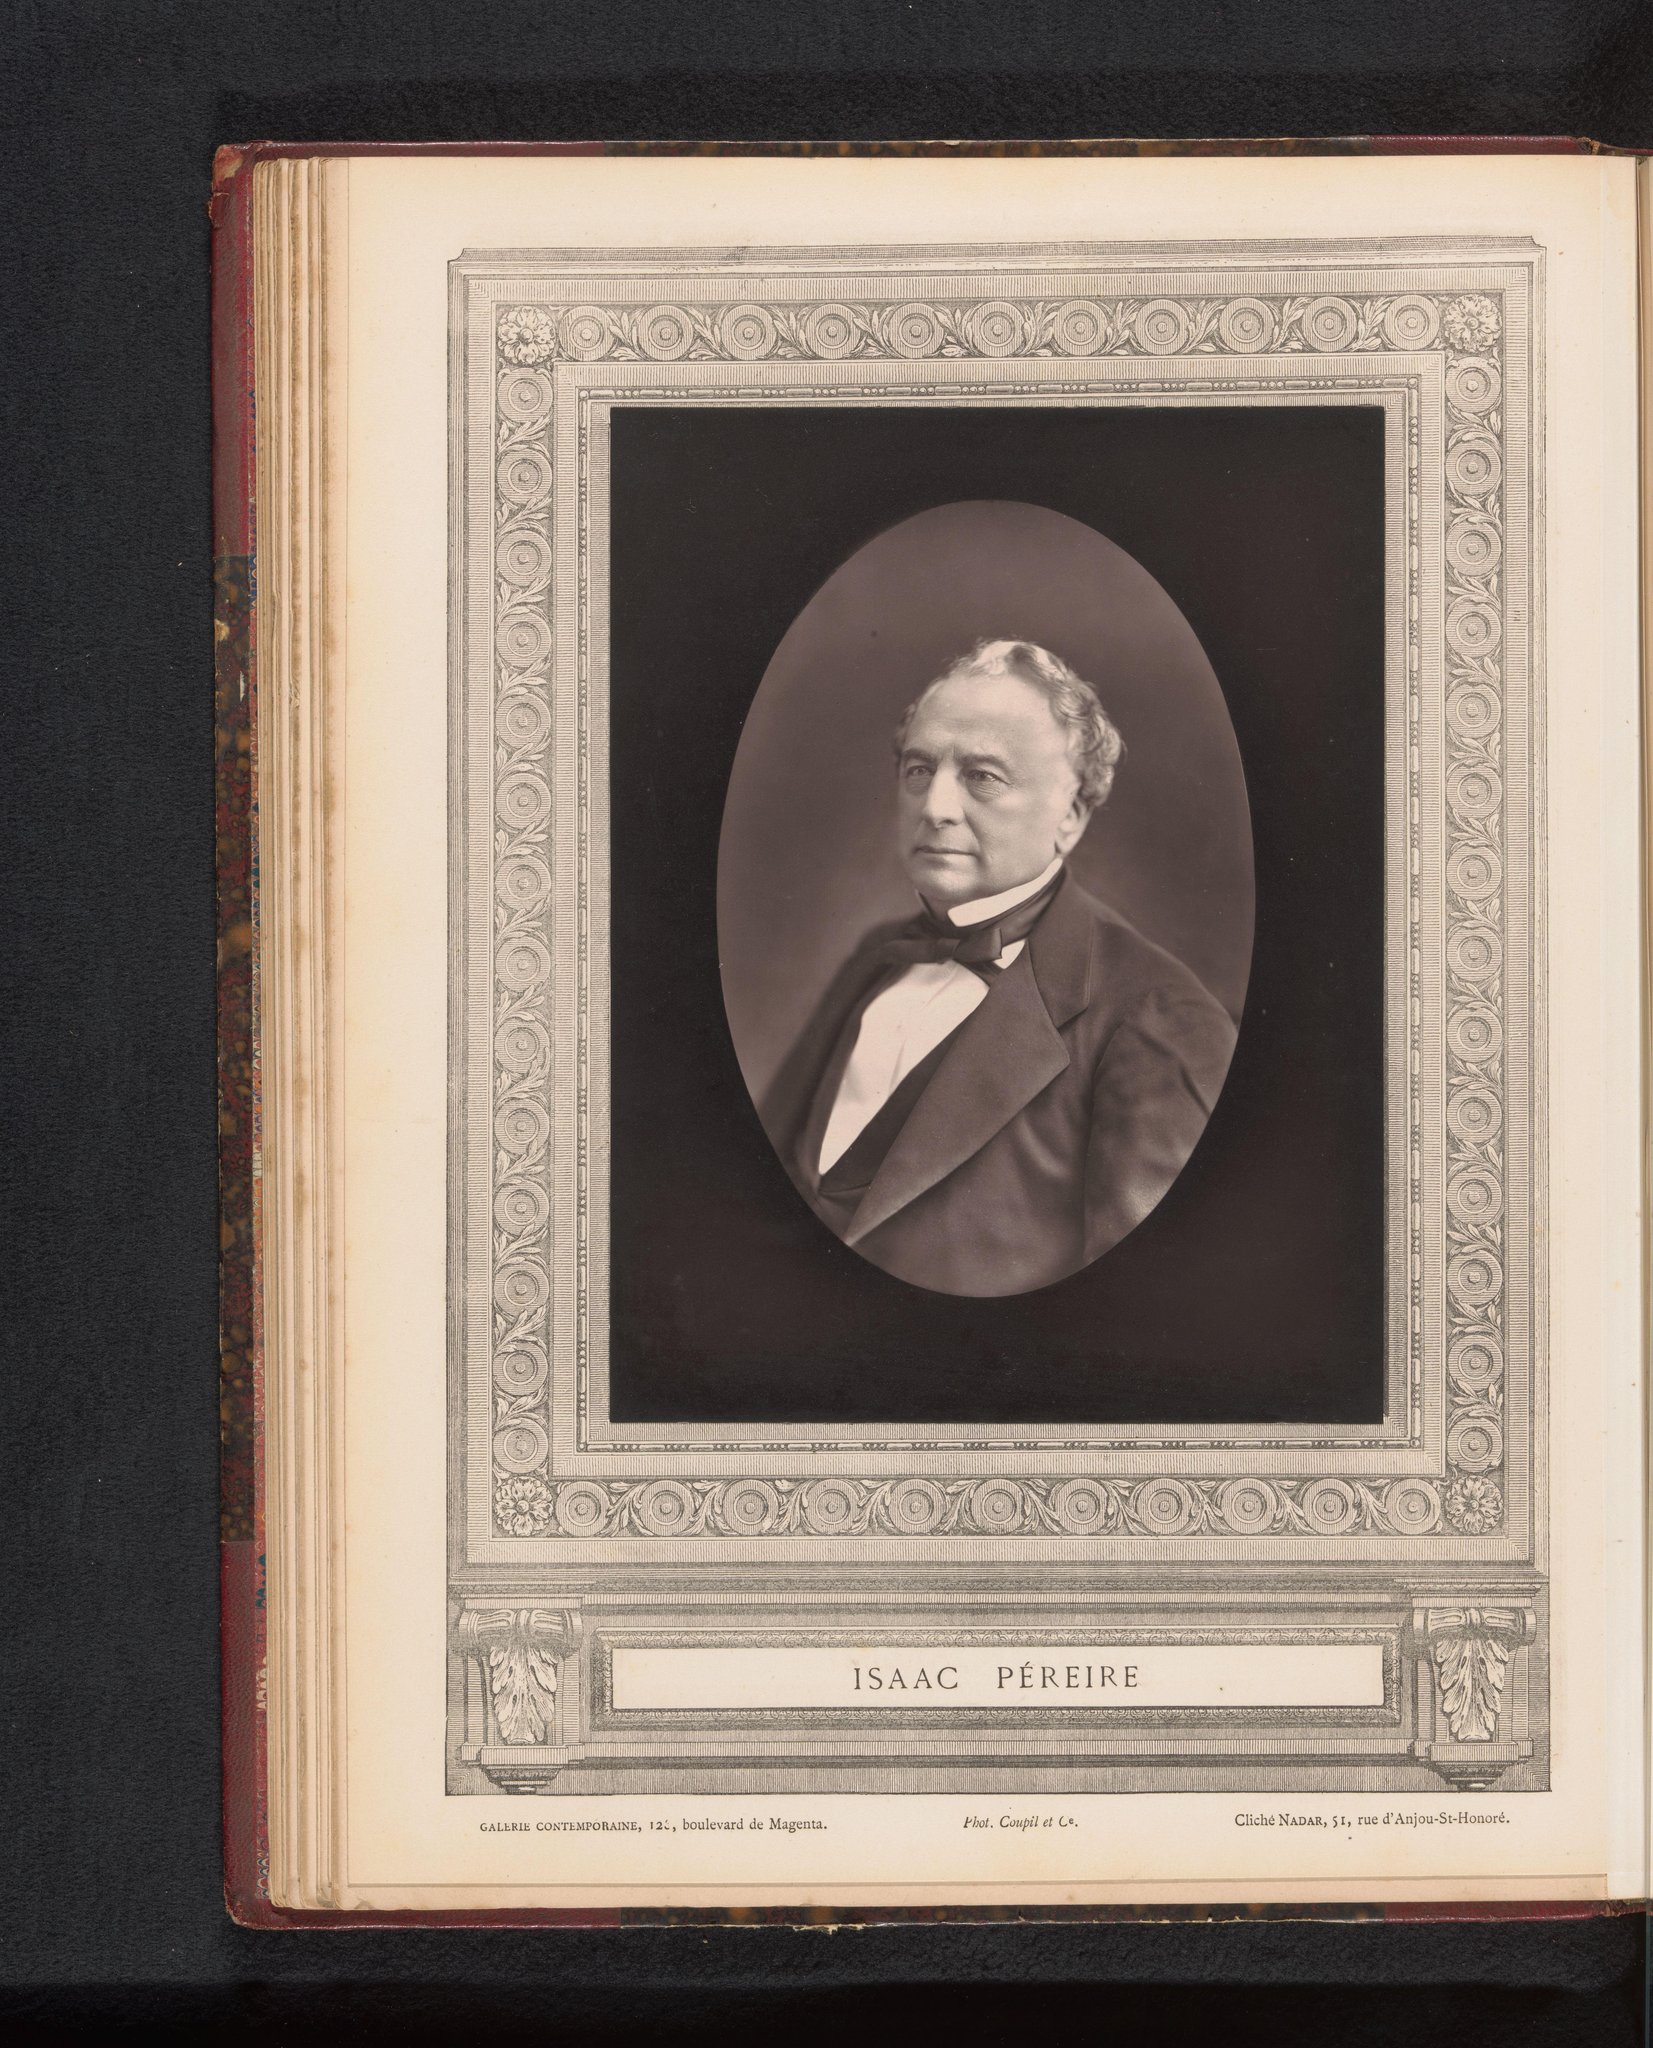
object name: photomechanical print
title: Portret van Isaac Péreire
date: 1872-1877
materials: paper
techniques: printing block, woodburytype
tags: adult man, historical persons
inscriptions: inscription: ‘Galerie Contemporaine, 126, boulevard de Magenta.’